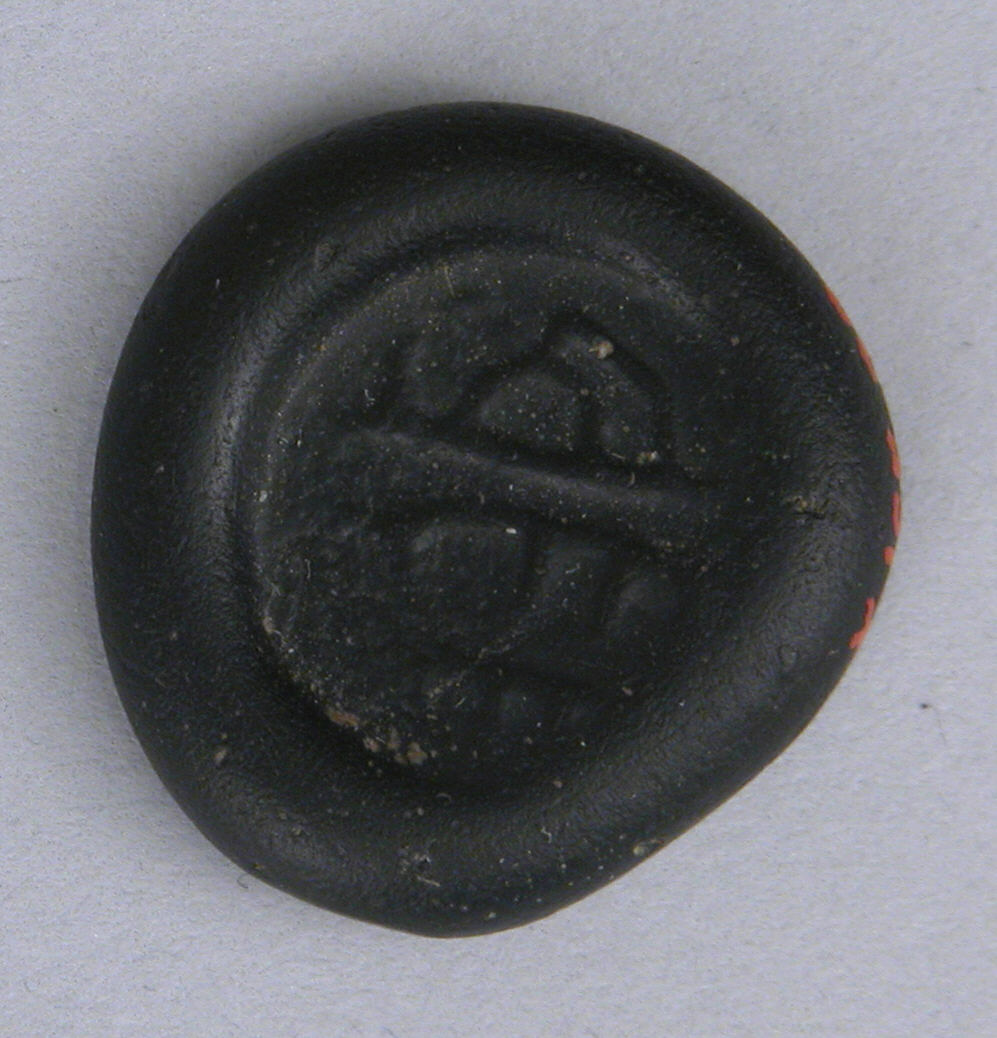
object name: coin weight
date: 1201-1600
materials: glass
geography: egypt